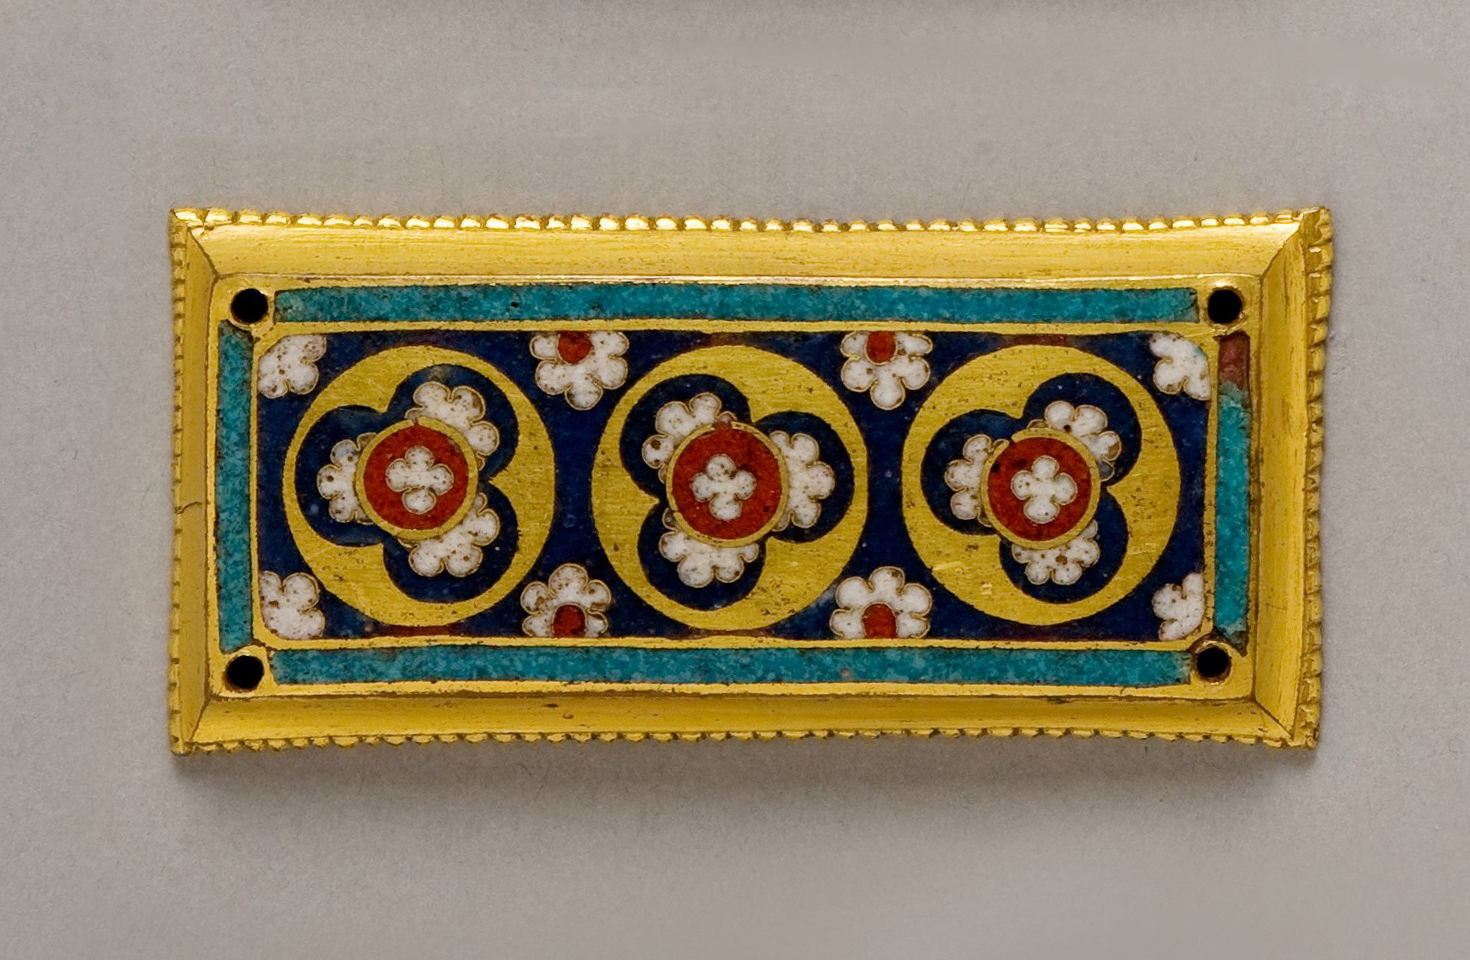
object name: plaque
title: Plaque from a Reliquary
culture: german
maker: master of the virgin mary's reliquary casket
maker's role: artist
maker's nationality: german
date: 1201-1233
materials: gilt copper, enamel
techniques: enamel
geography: germany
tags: reliquaries